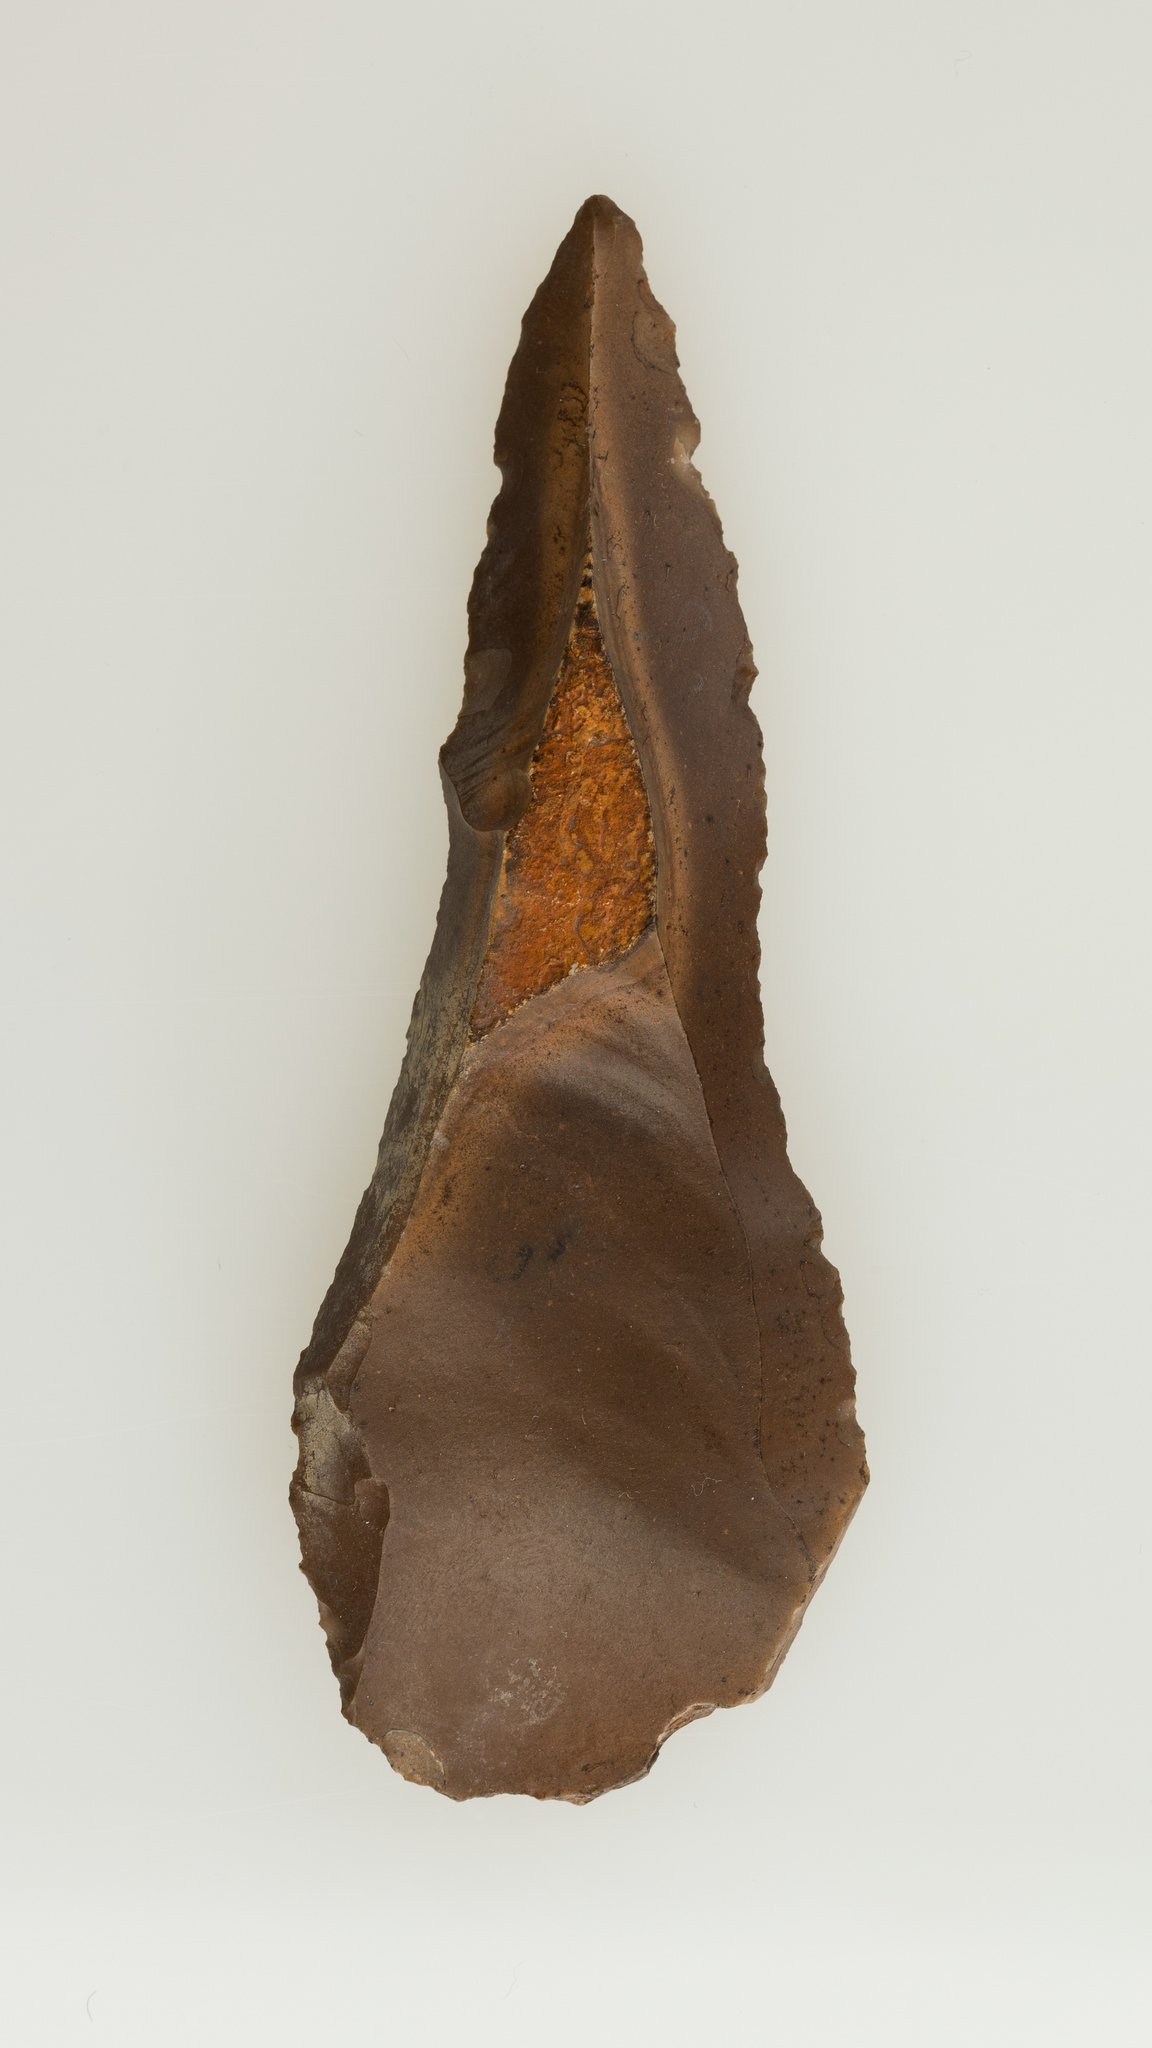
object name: tool, point, levallois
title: Retouched Levallois Point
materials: stone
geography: egypt